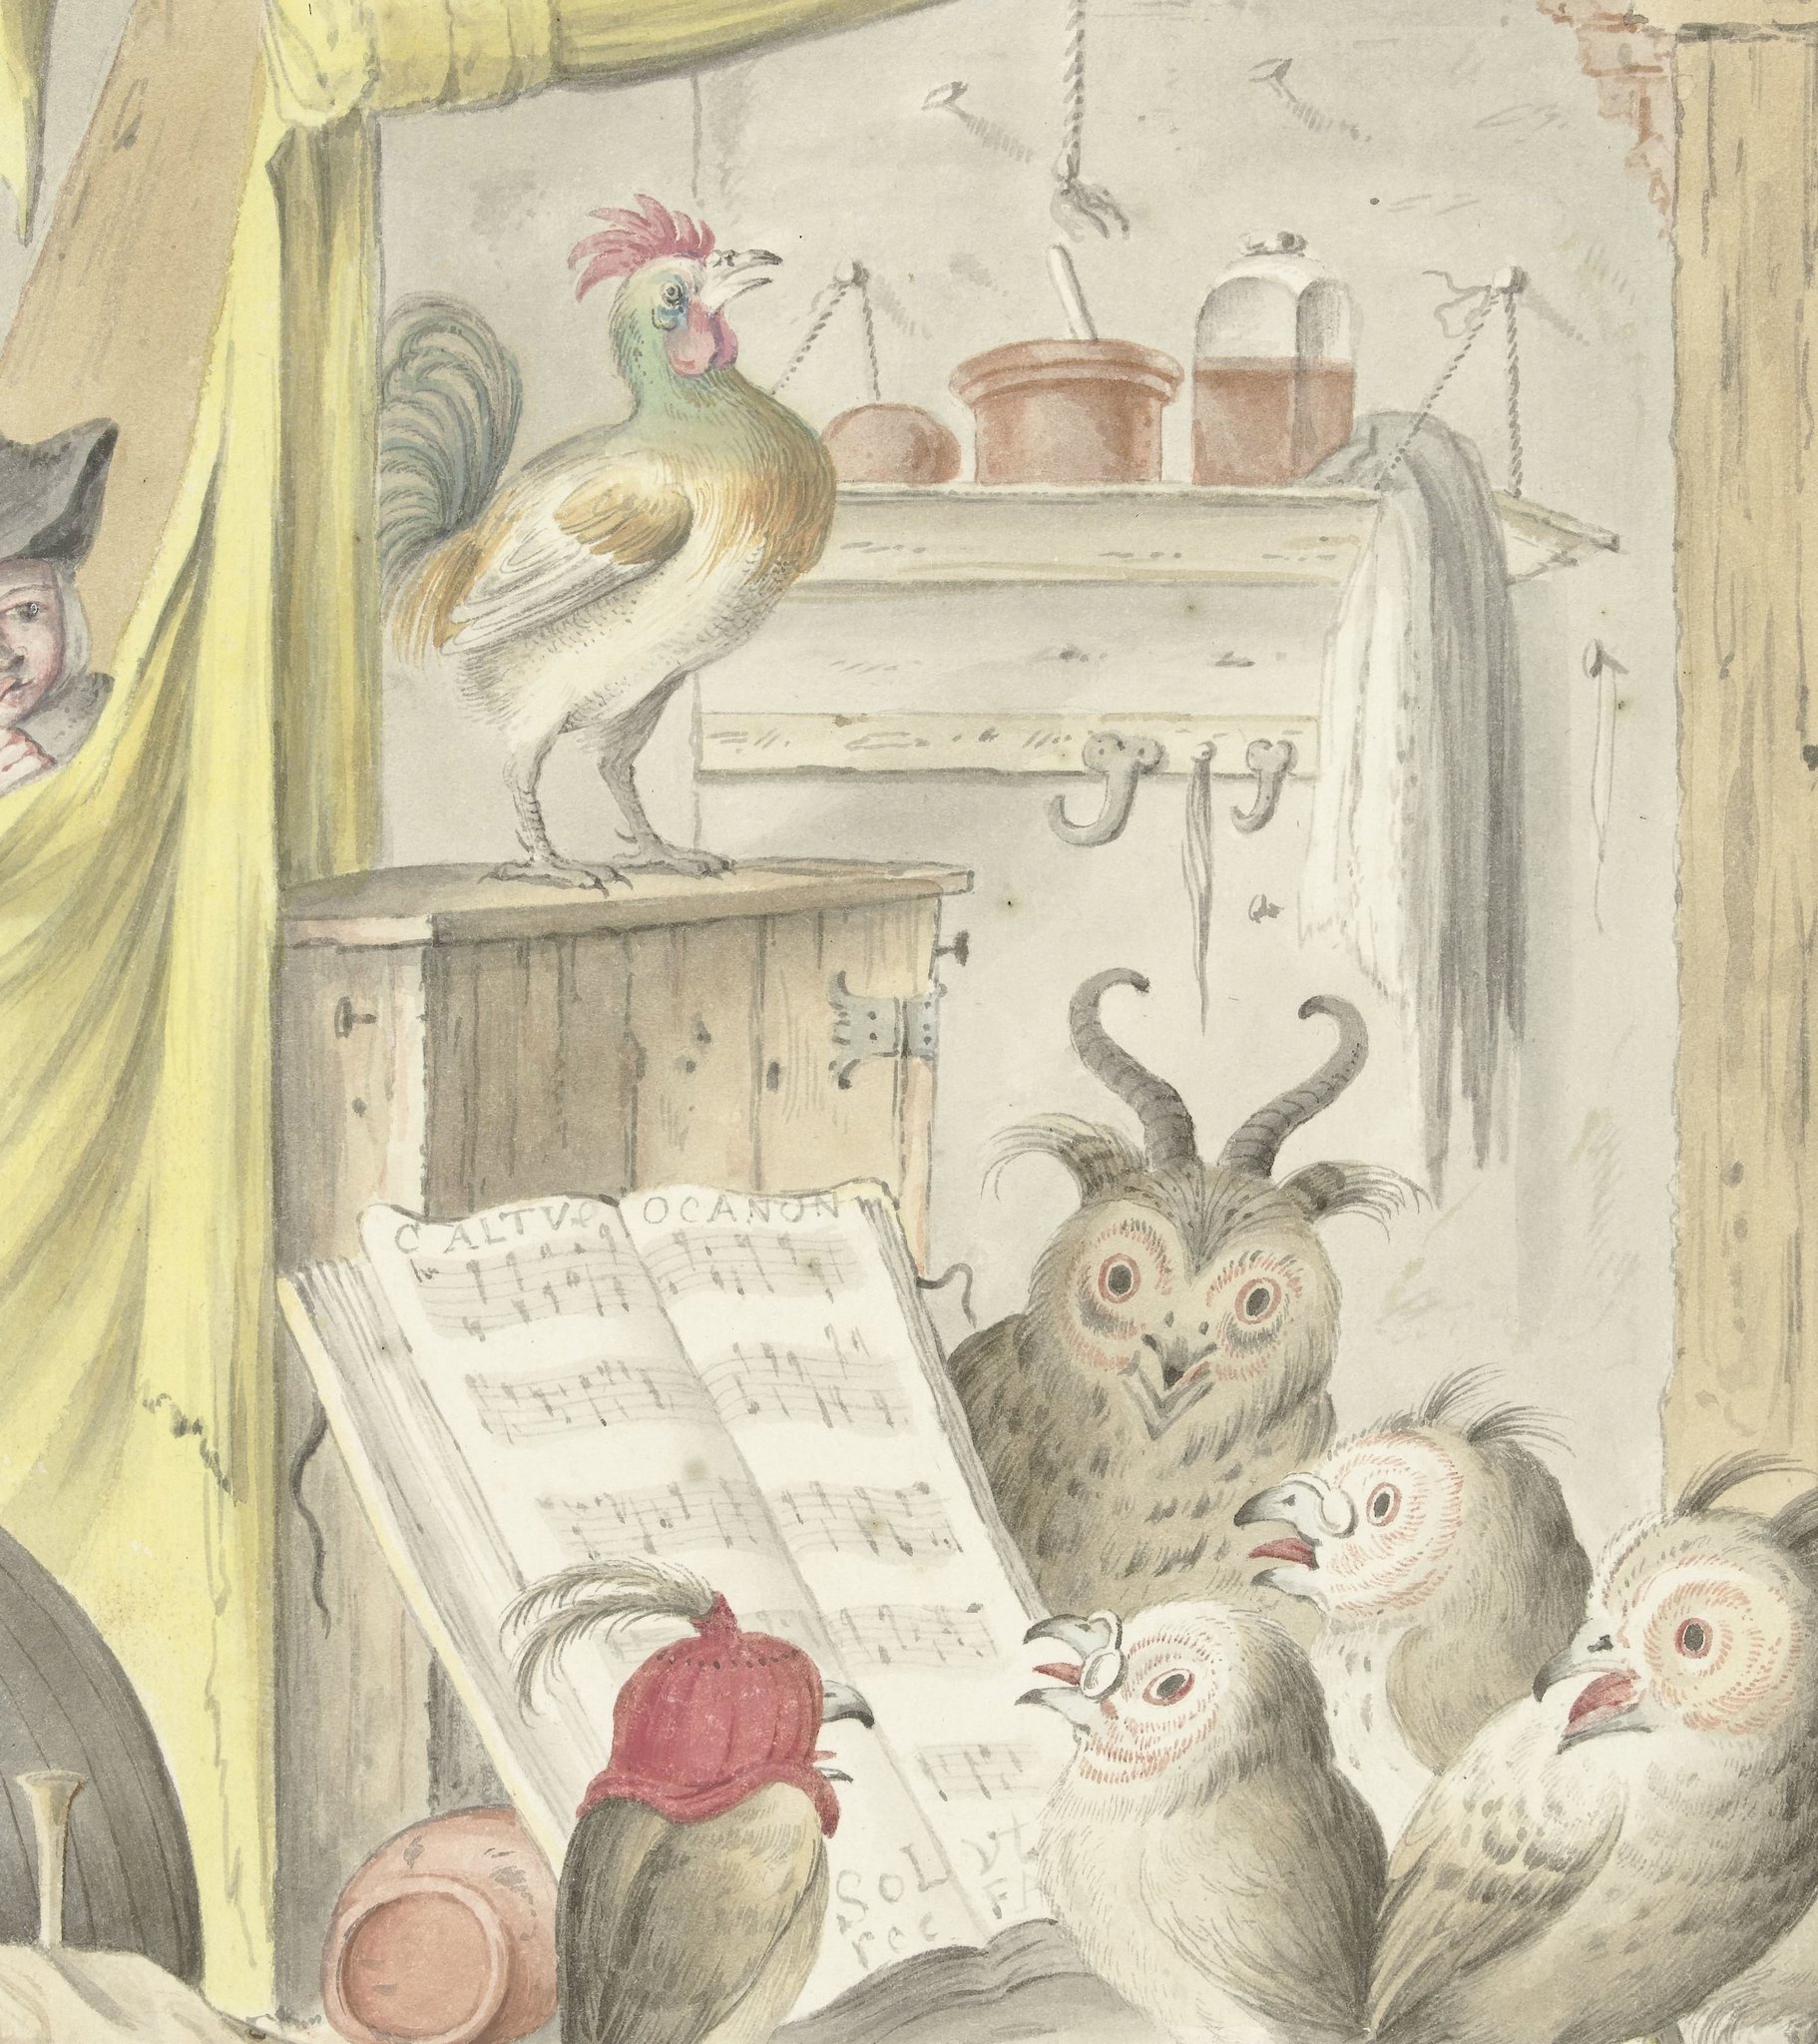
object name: drawing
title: Bird Concert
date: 1620-1715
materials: graphite, ink, paper, watercolor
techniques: brush, drawing, pen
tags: bagpipe, musette, animals acting as human beings, vocal music, singing, owls, fowl (cock, hen, chicken, etc.) (+ male animal), lute, and special forms of lute, e.g.: theorbo, conductor ~ music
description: Pendant van "Interieur met kattenconcert", inventarisnummer RP-T-00-347.